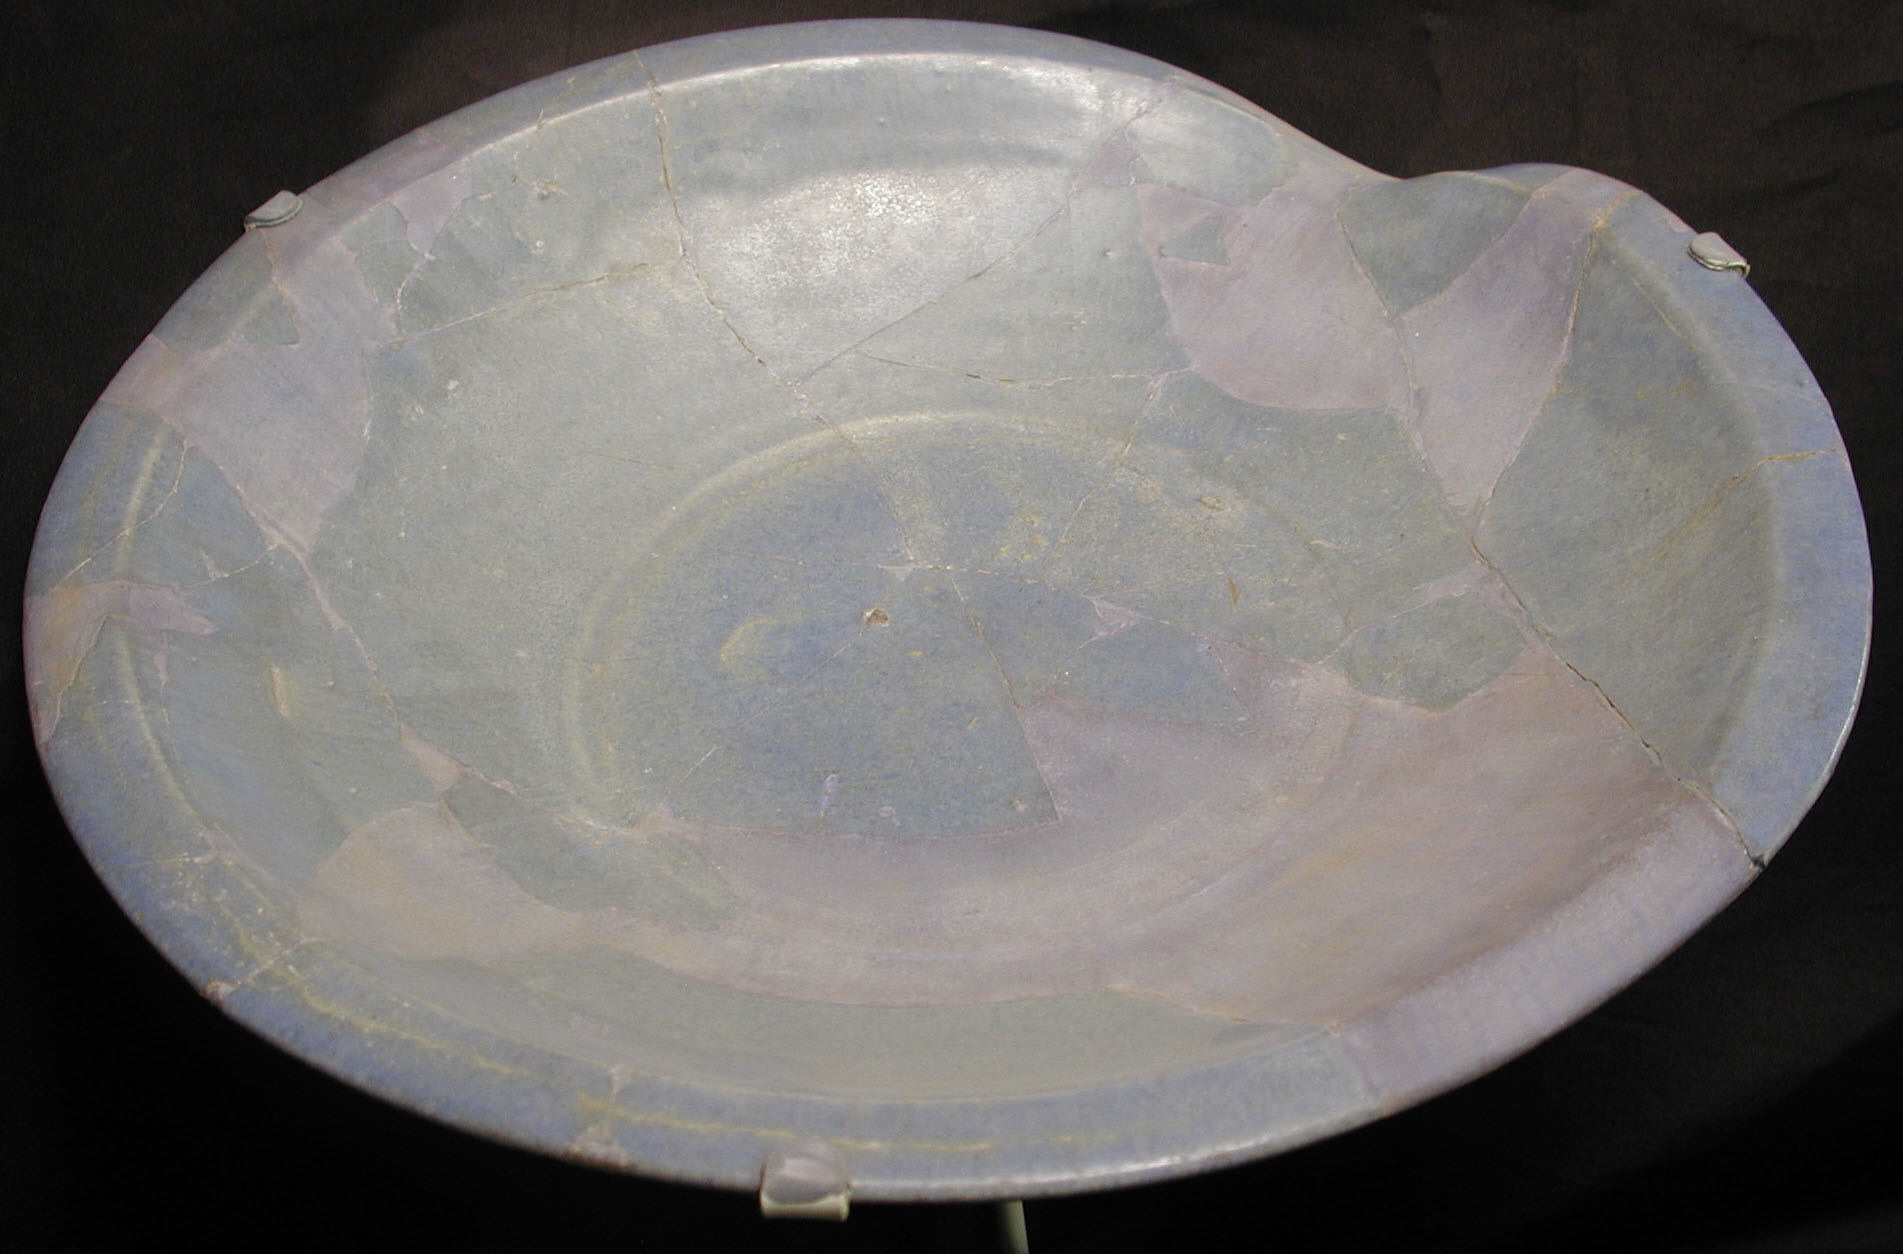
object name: plate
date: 1101-1200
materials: earthenware, glaze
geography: iran